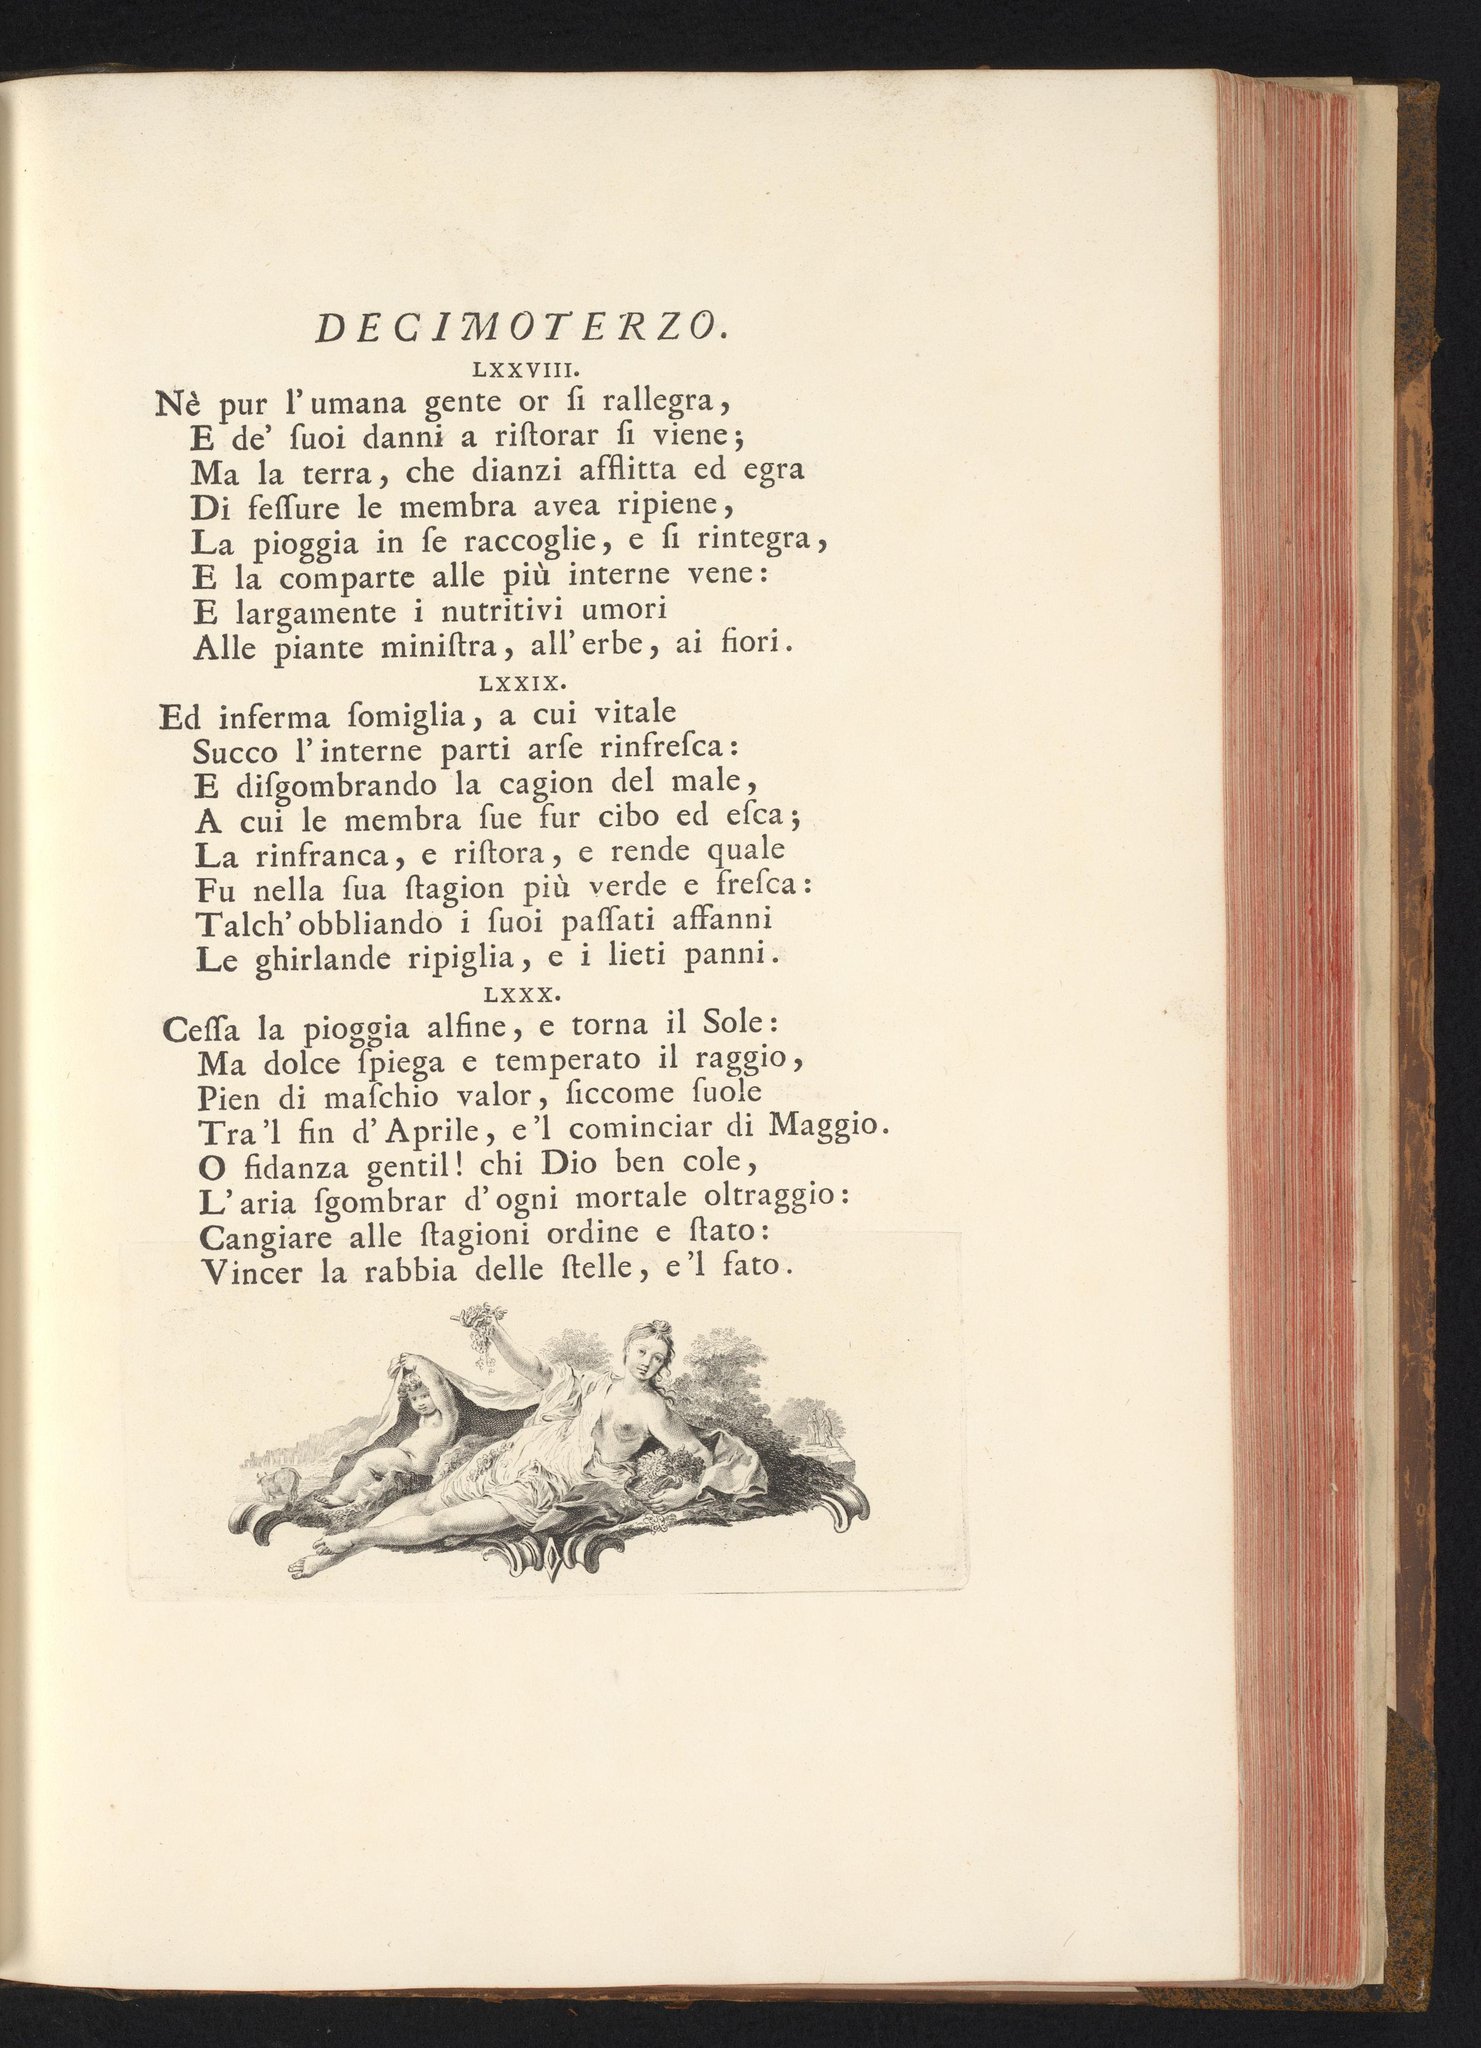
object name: page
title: Liggende vrouw met druiven en putto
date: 1745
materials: paper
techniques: etching, letterpress printing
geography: venice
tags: adult woman, (scenes from) specific works of literature: tasso, gerusalemme liberata, cupids: 'amores', 'amoretti', 'putti'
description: Prent uit: Tasso, Torquato. La Gerusalemme liberata di Torquato Tasso con le figure de Giambatista Piazzetta. Venetië: Giambatista Albrizzi, 1745.